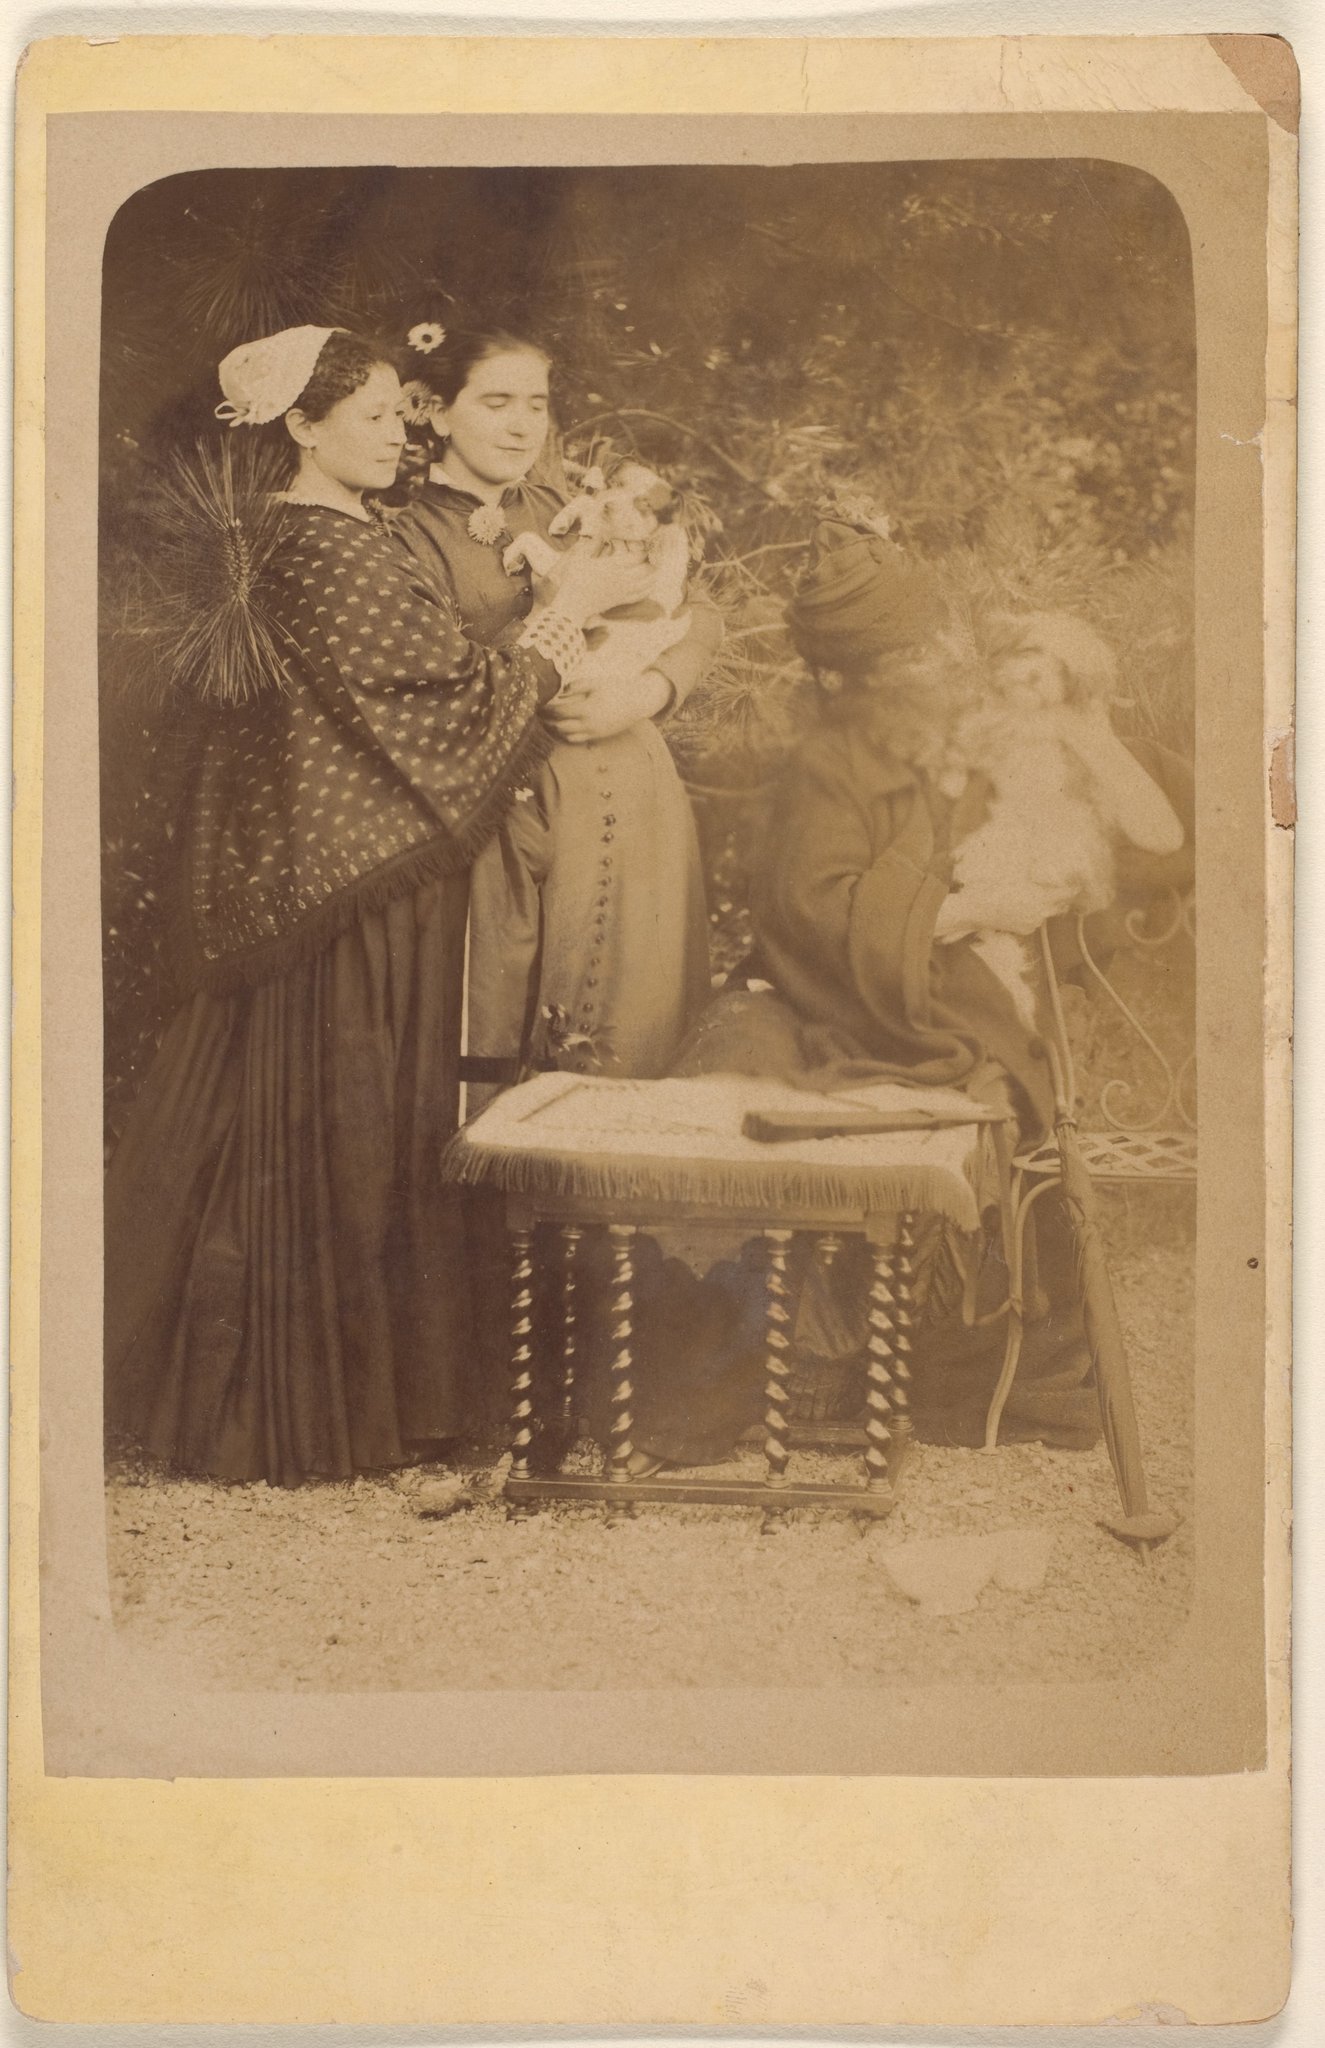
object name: photograph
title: Les Chiens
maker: pierre-louis pierson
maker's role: artist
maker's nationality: french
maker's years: 1822-1913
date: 1860-1869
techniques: albumen silver print, glass negative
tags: men,portraits,women,dogs